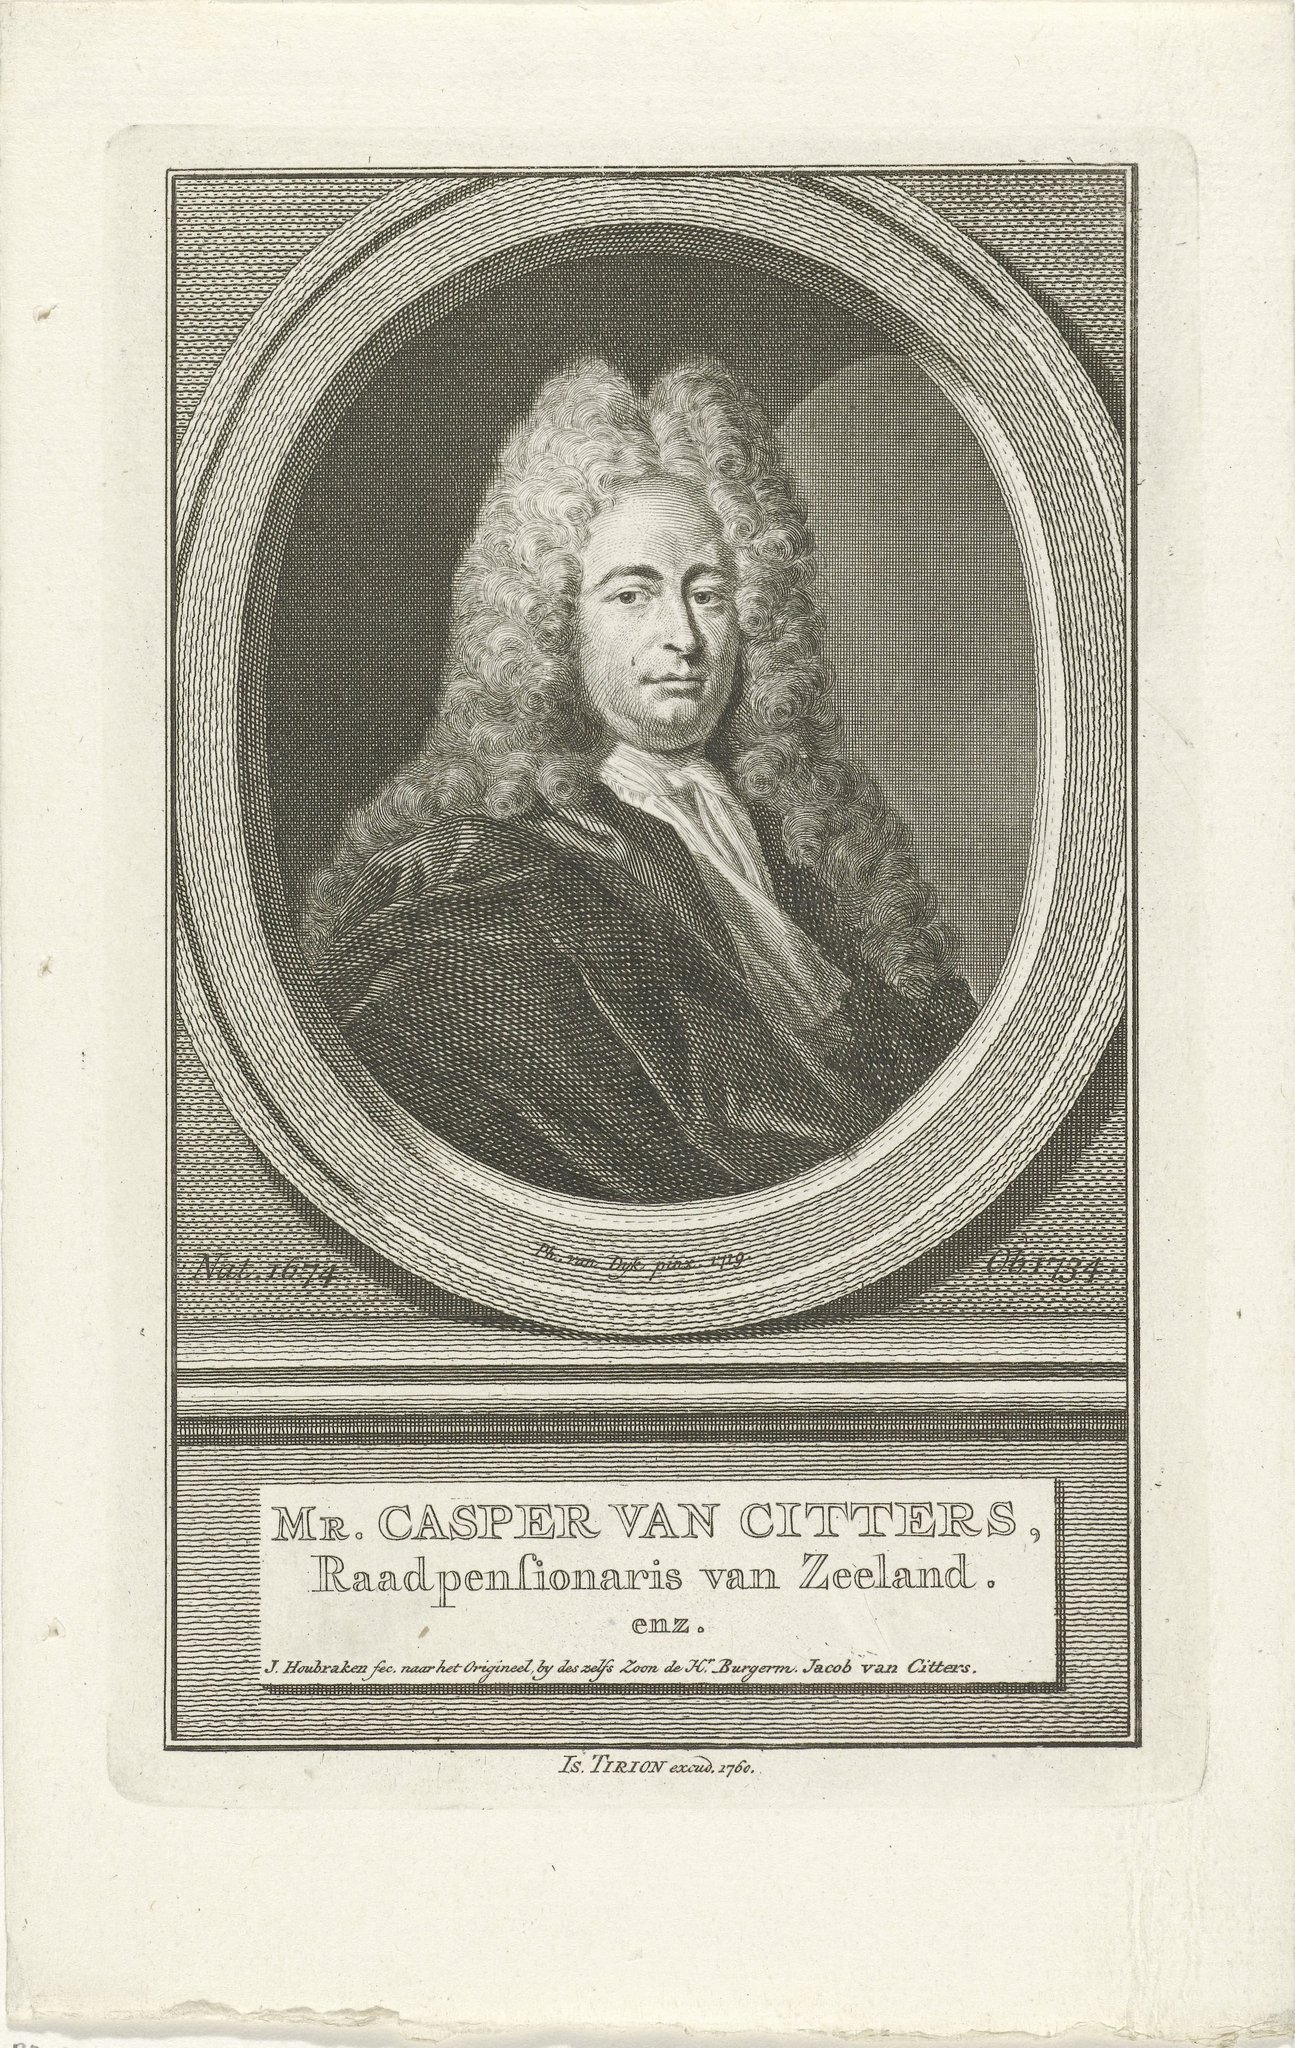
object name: print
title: Portret van Casper van Citters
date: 1760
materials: paper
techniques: engraving, etching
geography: amsterdam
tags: casper van citters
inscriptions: collector's mark: Lugt 2228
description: Prent volgens Ver Huell ook gebruikt in: Portraiten van eenige der vermaardste staatsmannen en zeehelden, als toevoeging op: Willem Tiberius Hattinga, Atlas van Zeeland. Amsterdam: Isaak Tirion, 1760. Prent ook gebruikt in: Portraiten van vermaarde persoonadien, dienende tot een aanhangsel op de Vaderlandsche historie. Amsterdam, Isaak Tirion, 1761.